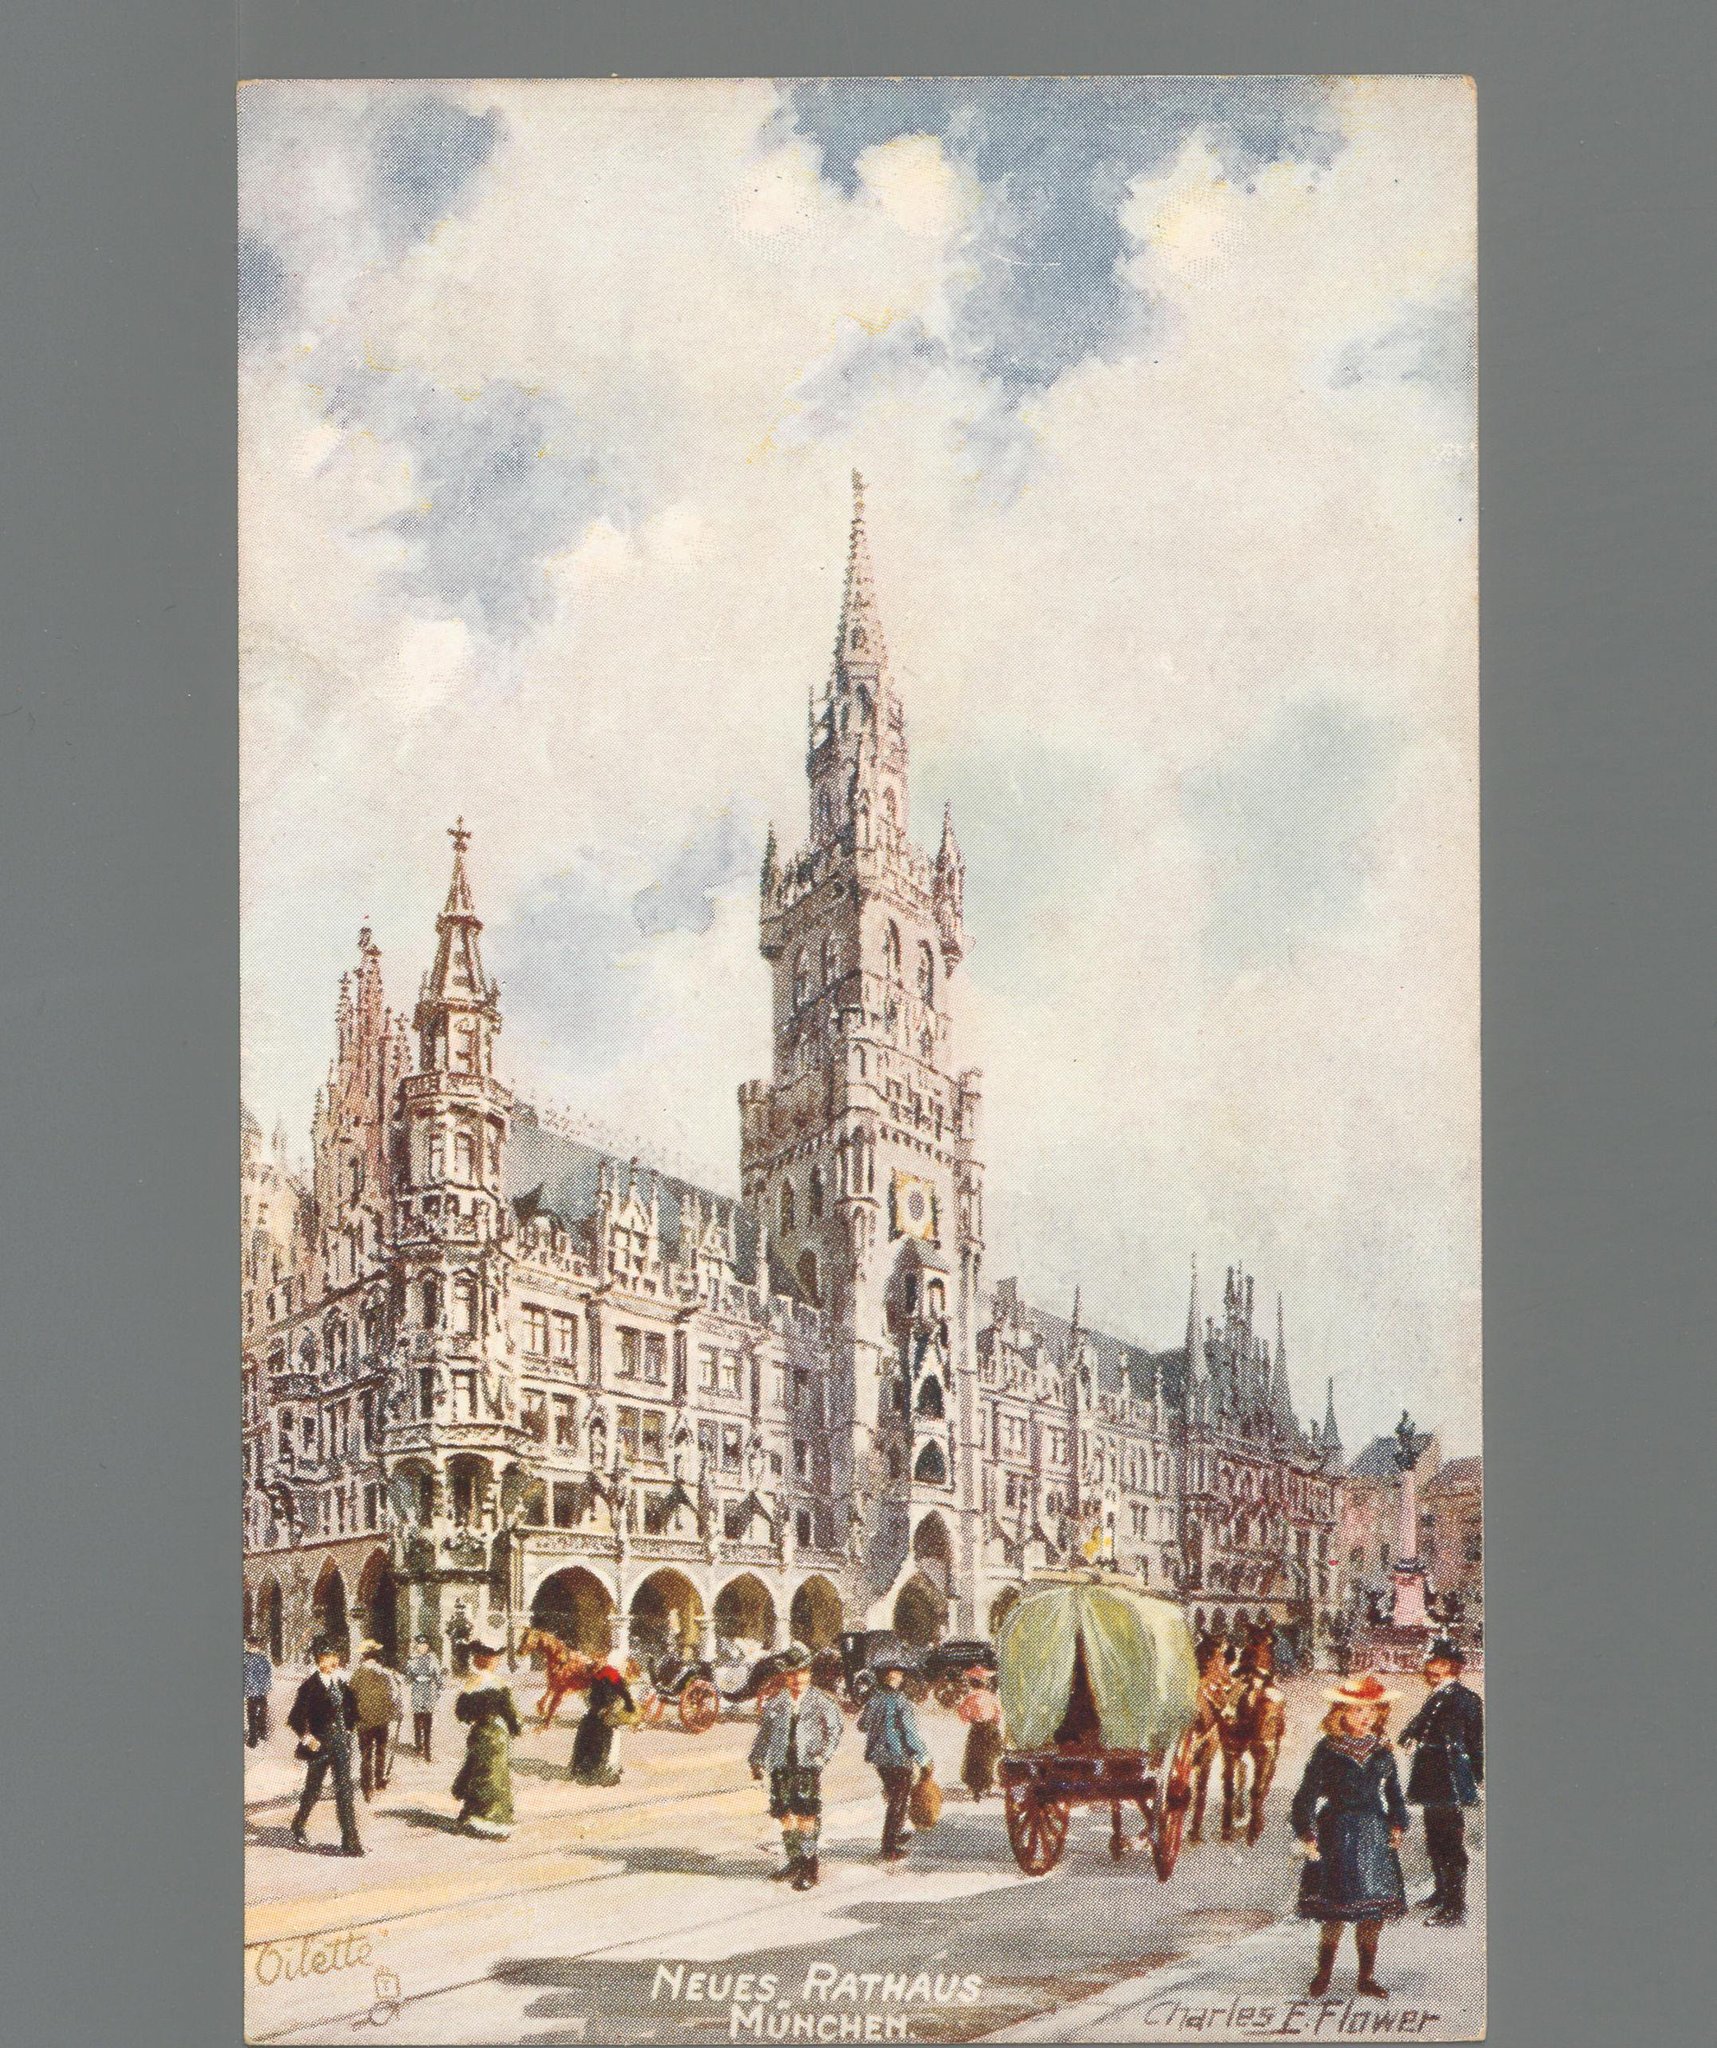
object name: photomechanical print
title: Oilette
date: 1907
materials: cardboard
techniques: writing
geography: london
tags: townhall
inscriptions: inscription: ‘A.K.M.’